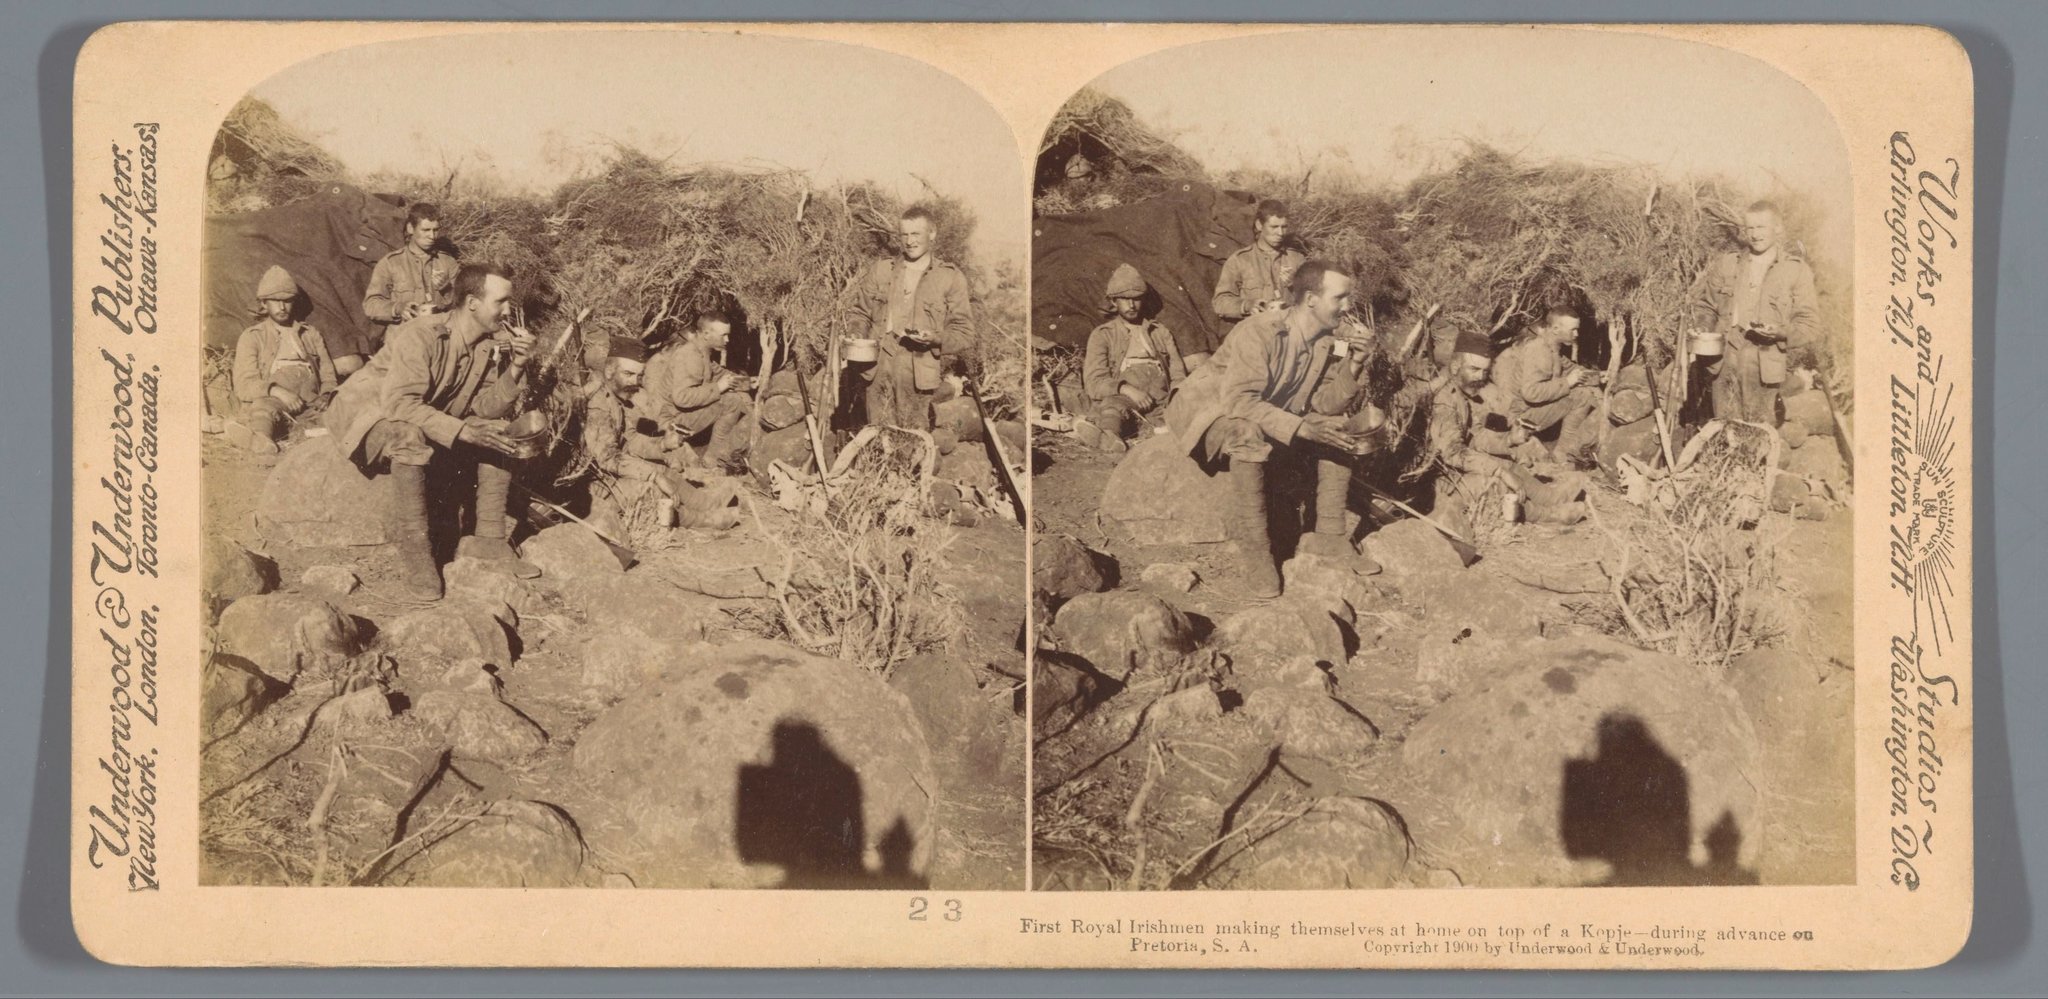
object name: stereograph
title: Britse soldaten zittend op een heuvel tijdens de opmars naar Pretoria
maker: Anonymous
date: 1900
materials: cardboard, paper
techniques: albumen print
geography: new york city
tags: the soldier; the soldier's life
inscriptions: number: ‘23’, copyright notice: ‘Copyright 1900 by Underwood & Underwood.’, inscription, inscription: ‘Works and Studios ~/ Arlington, N.J. Littleton, N.H. Washington, D.C.’